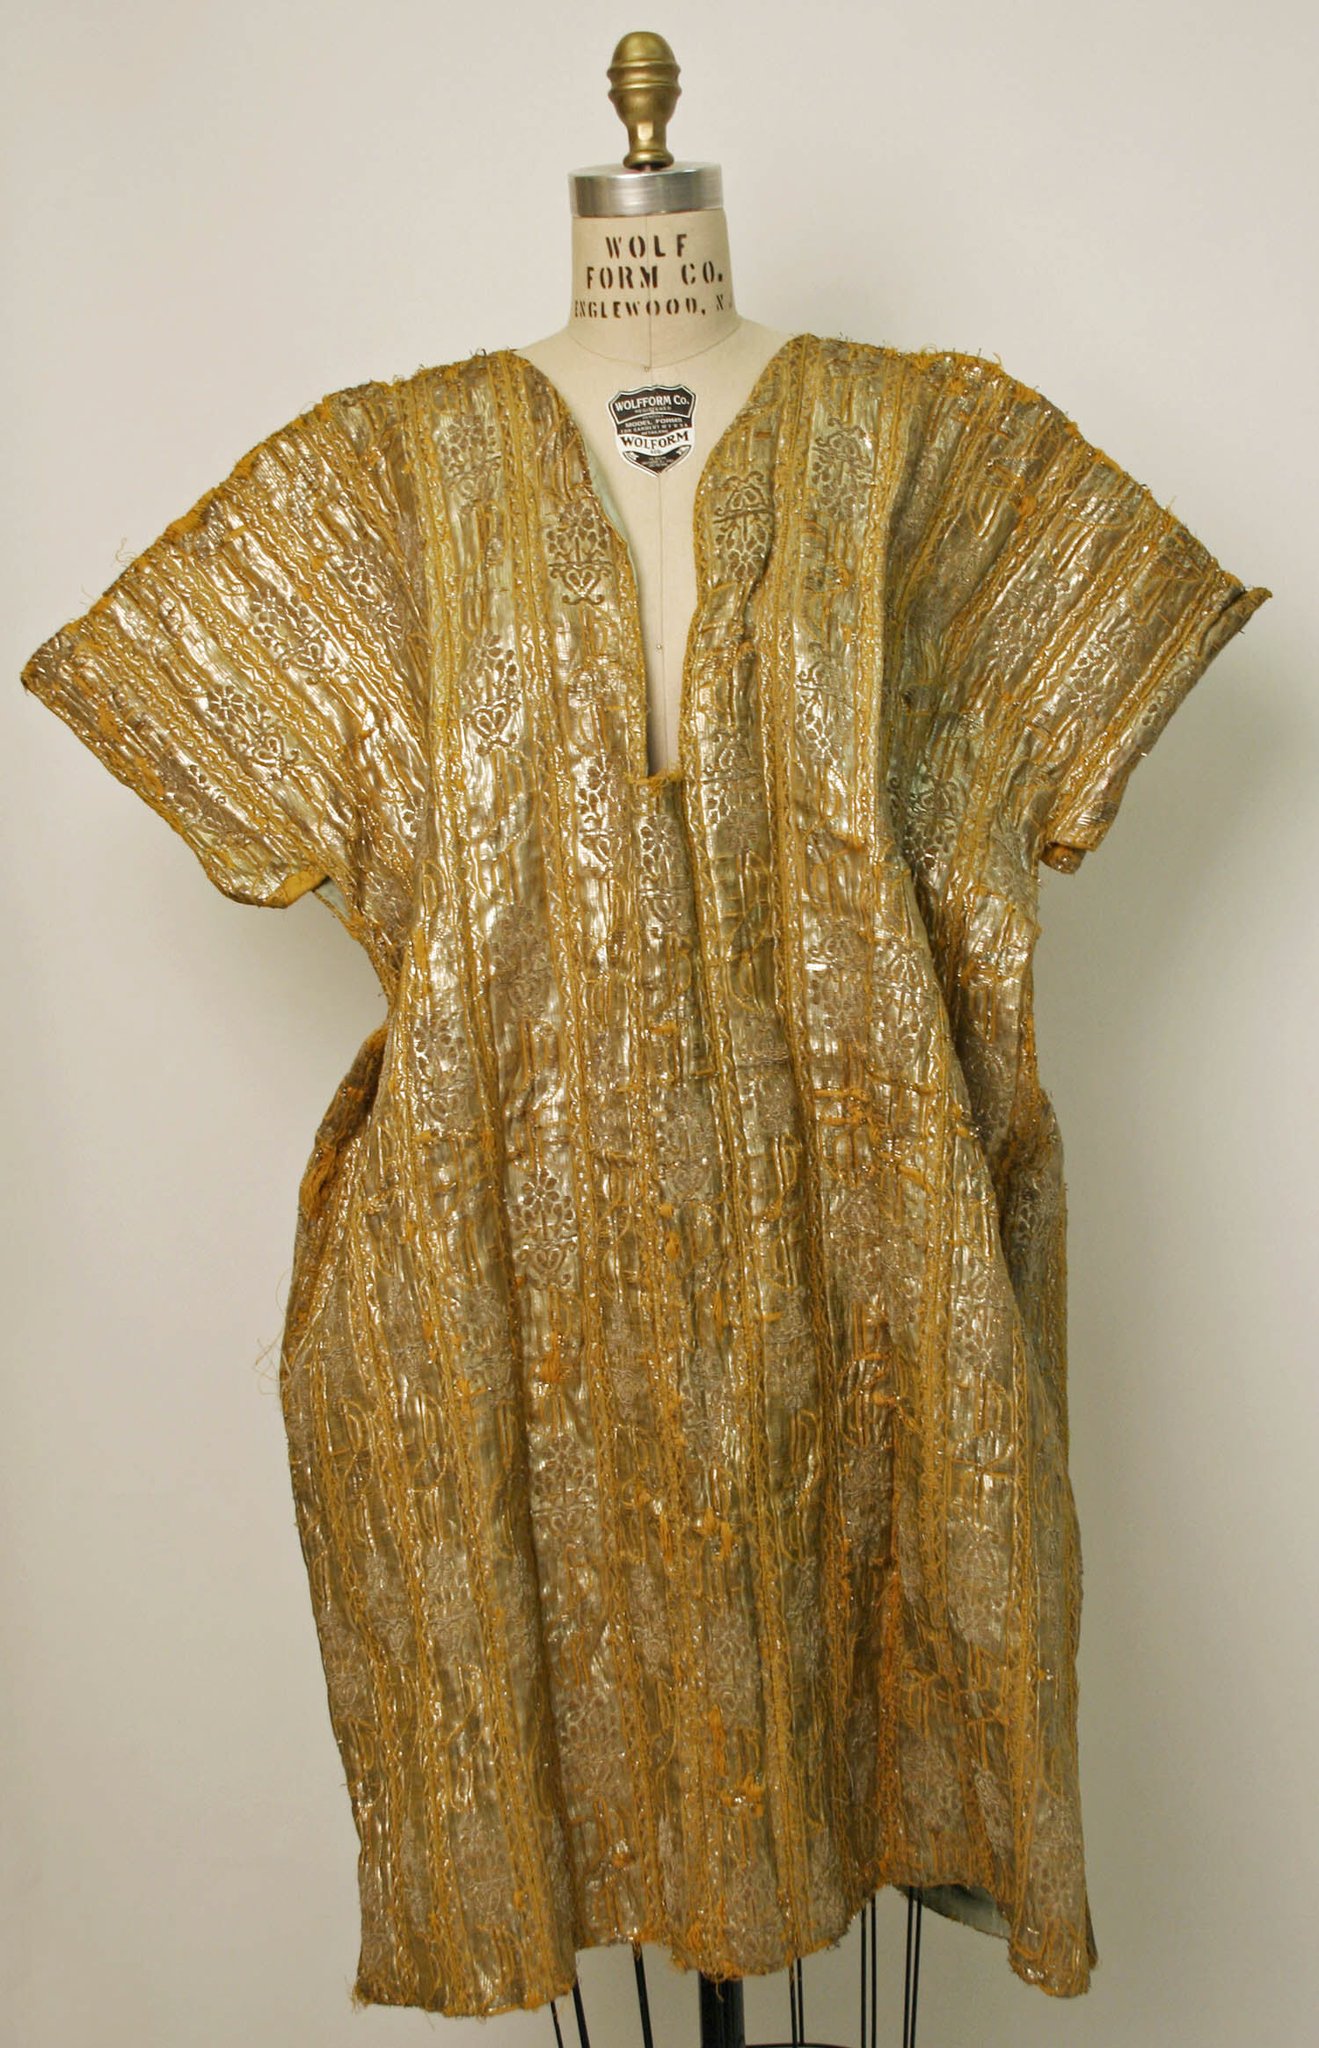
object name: wedding tunic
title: Wedding Tunic and Ensemble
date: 1867-1900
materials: cotton, metal thread, velvet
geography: tunisia